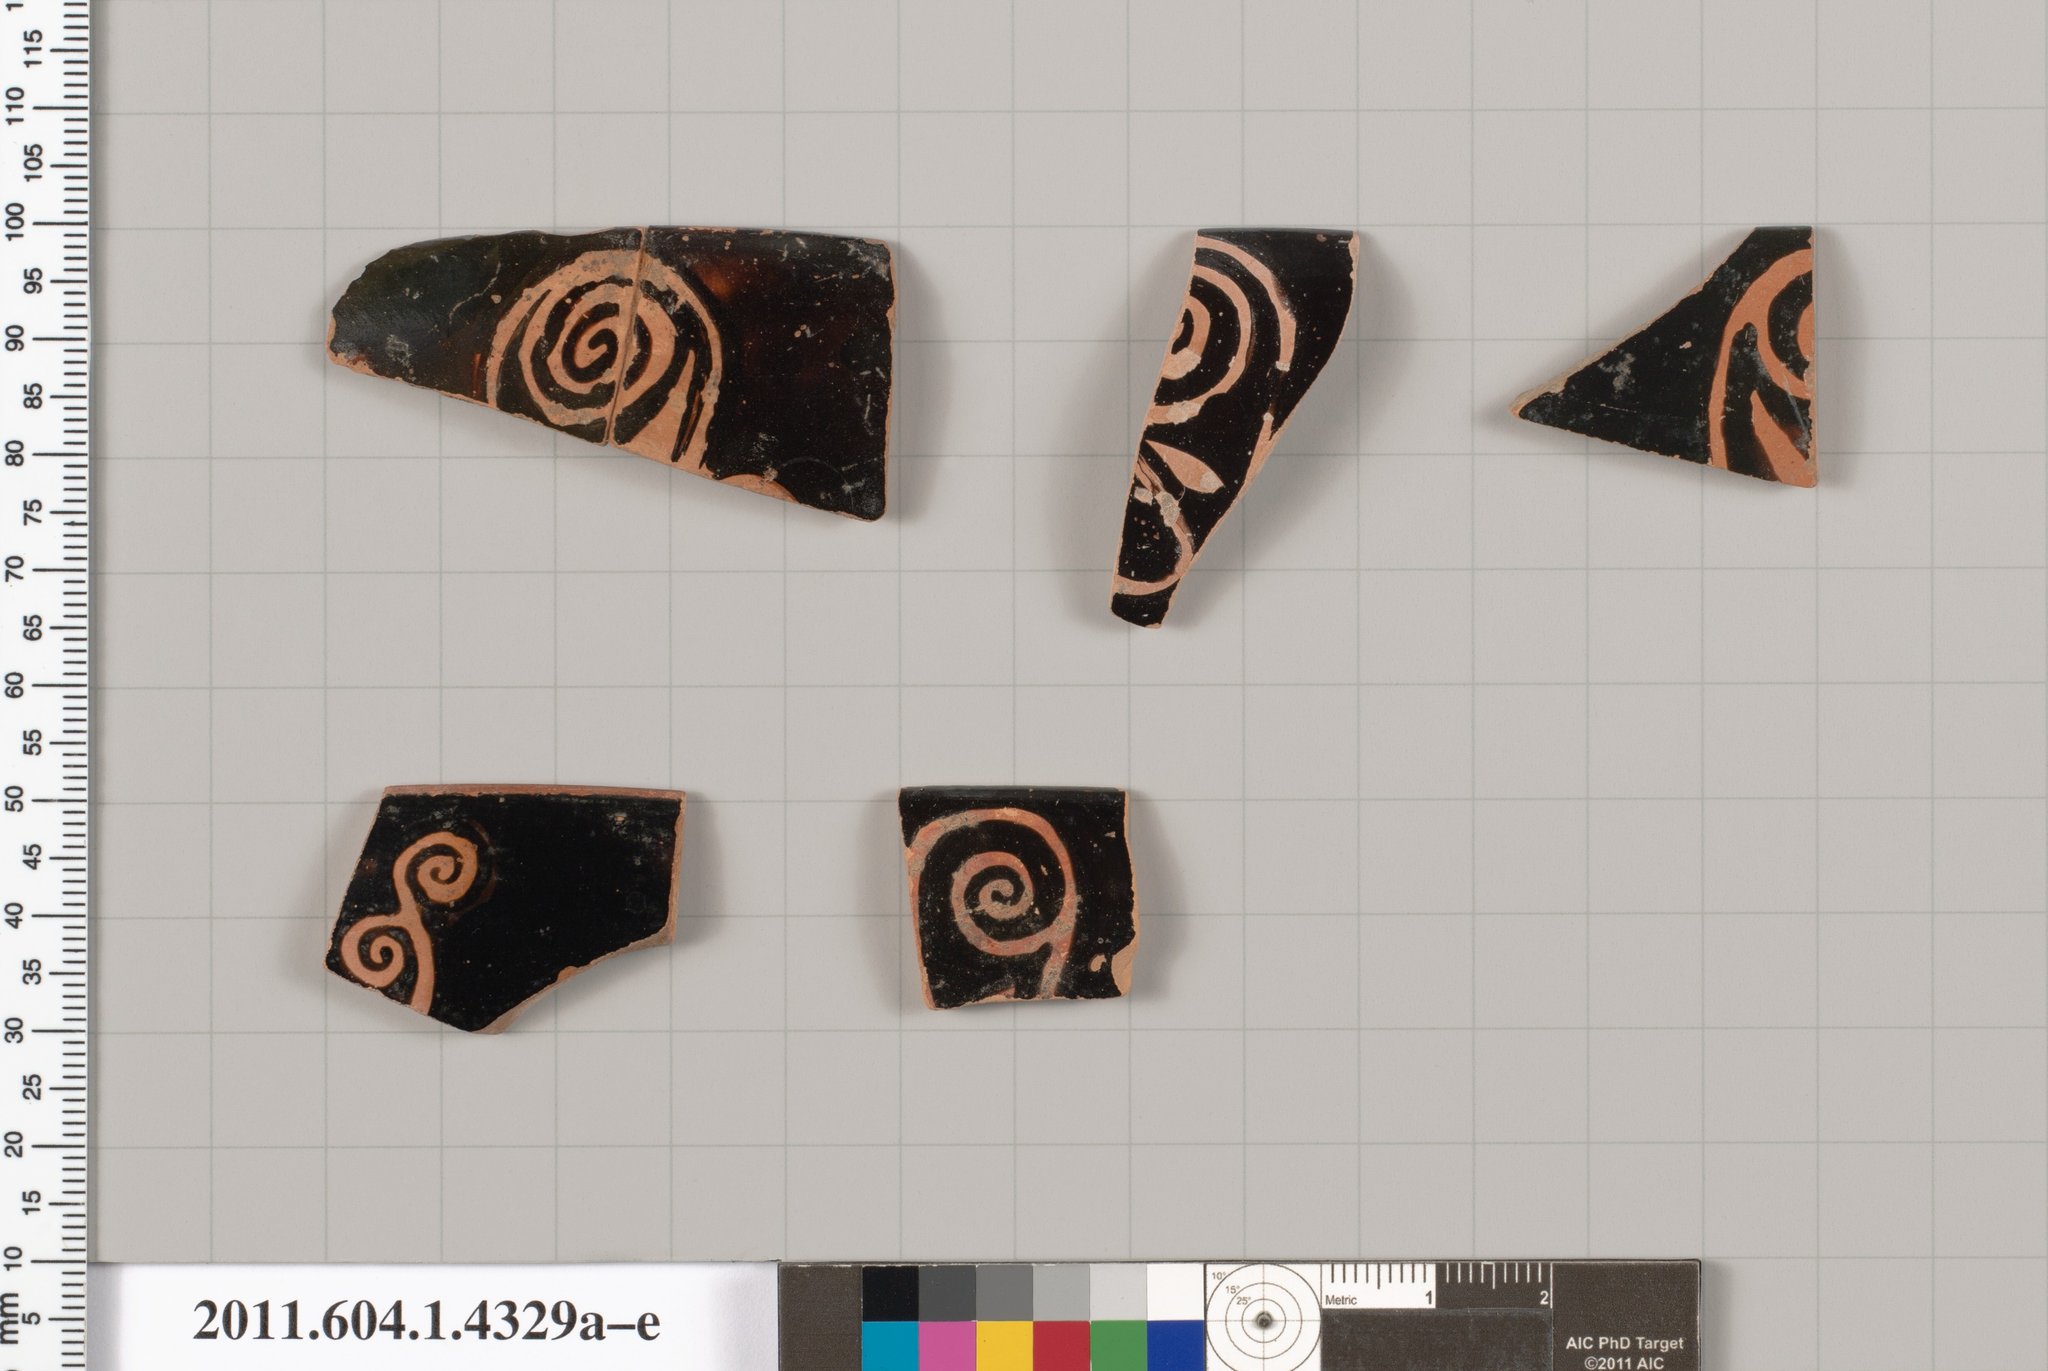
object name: kylix fragment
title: Terracotta rim fragments of kylikes (drinking cups)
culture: greek, attic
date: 500-451 BCE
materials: terracotta